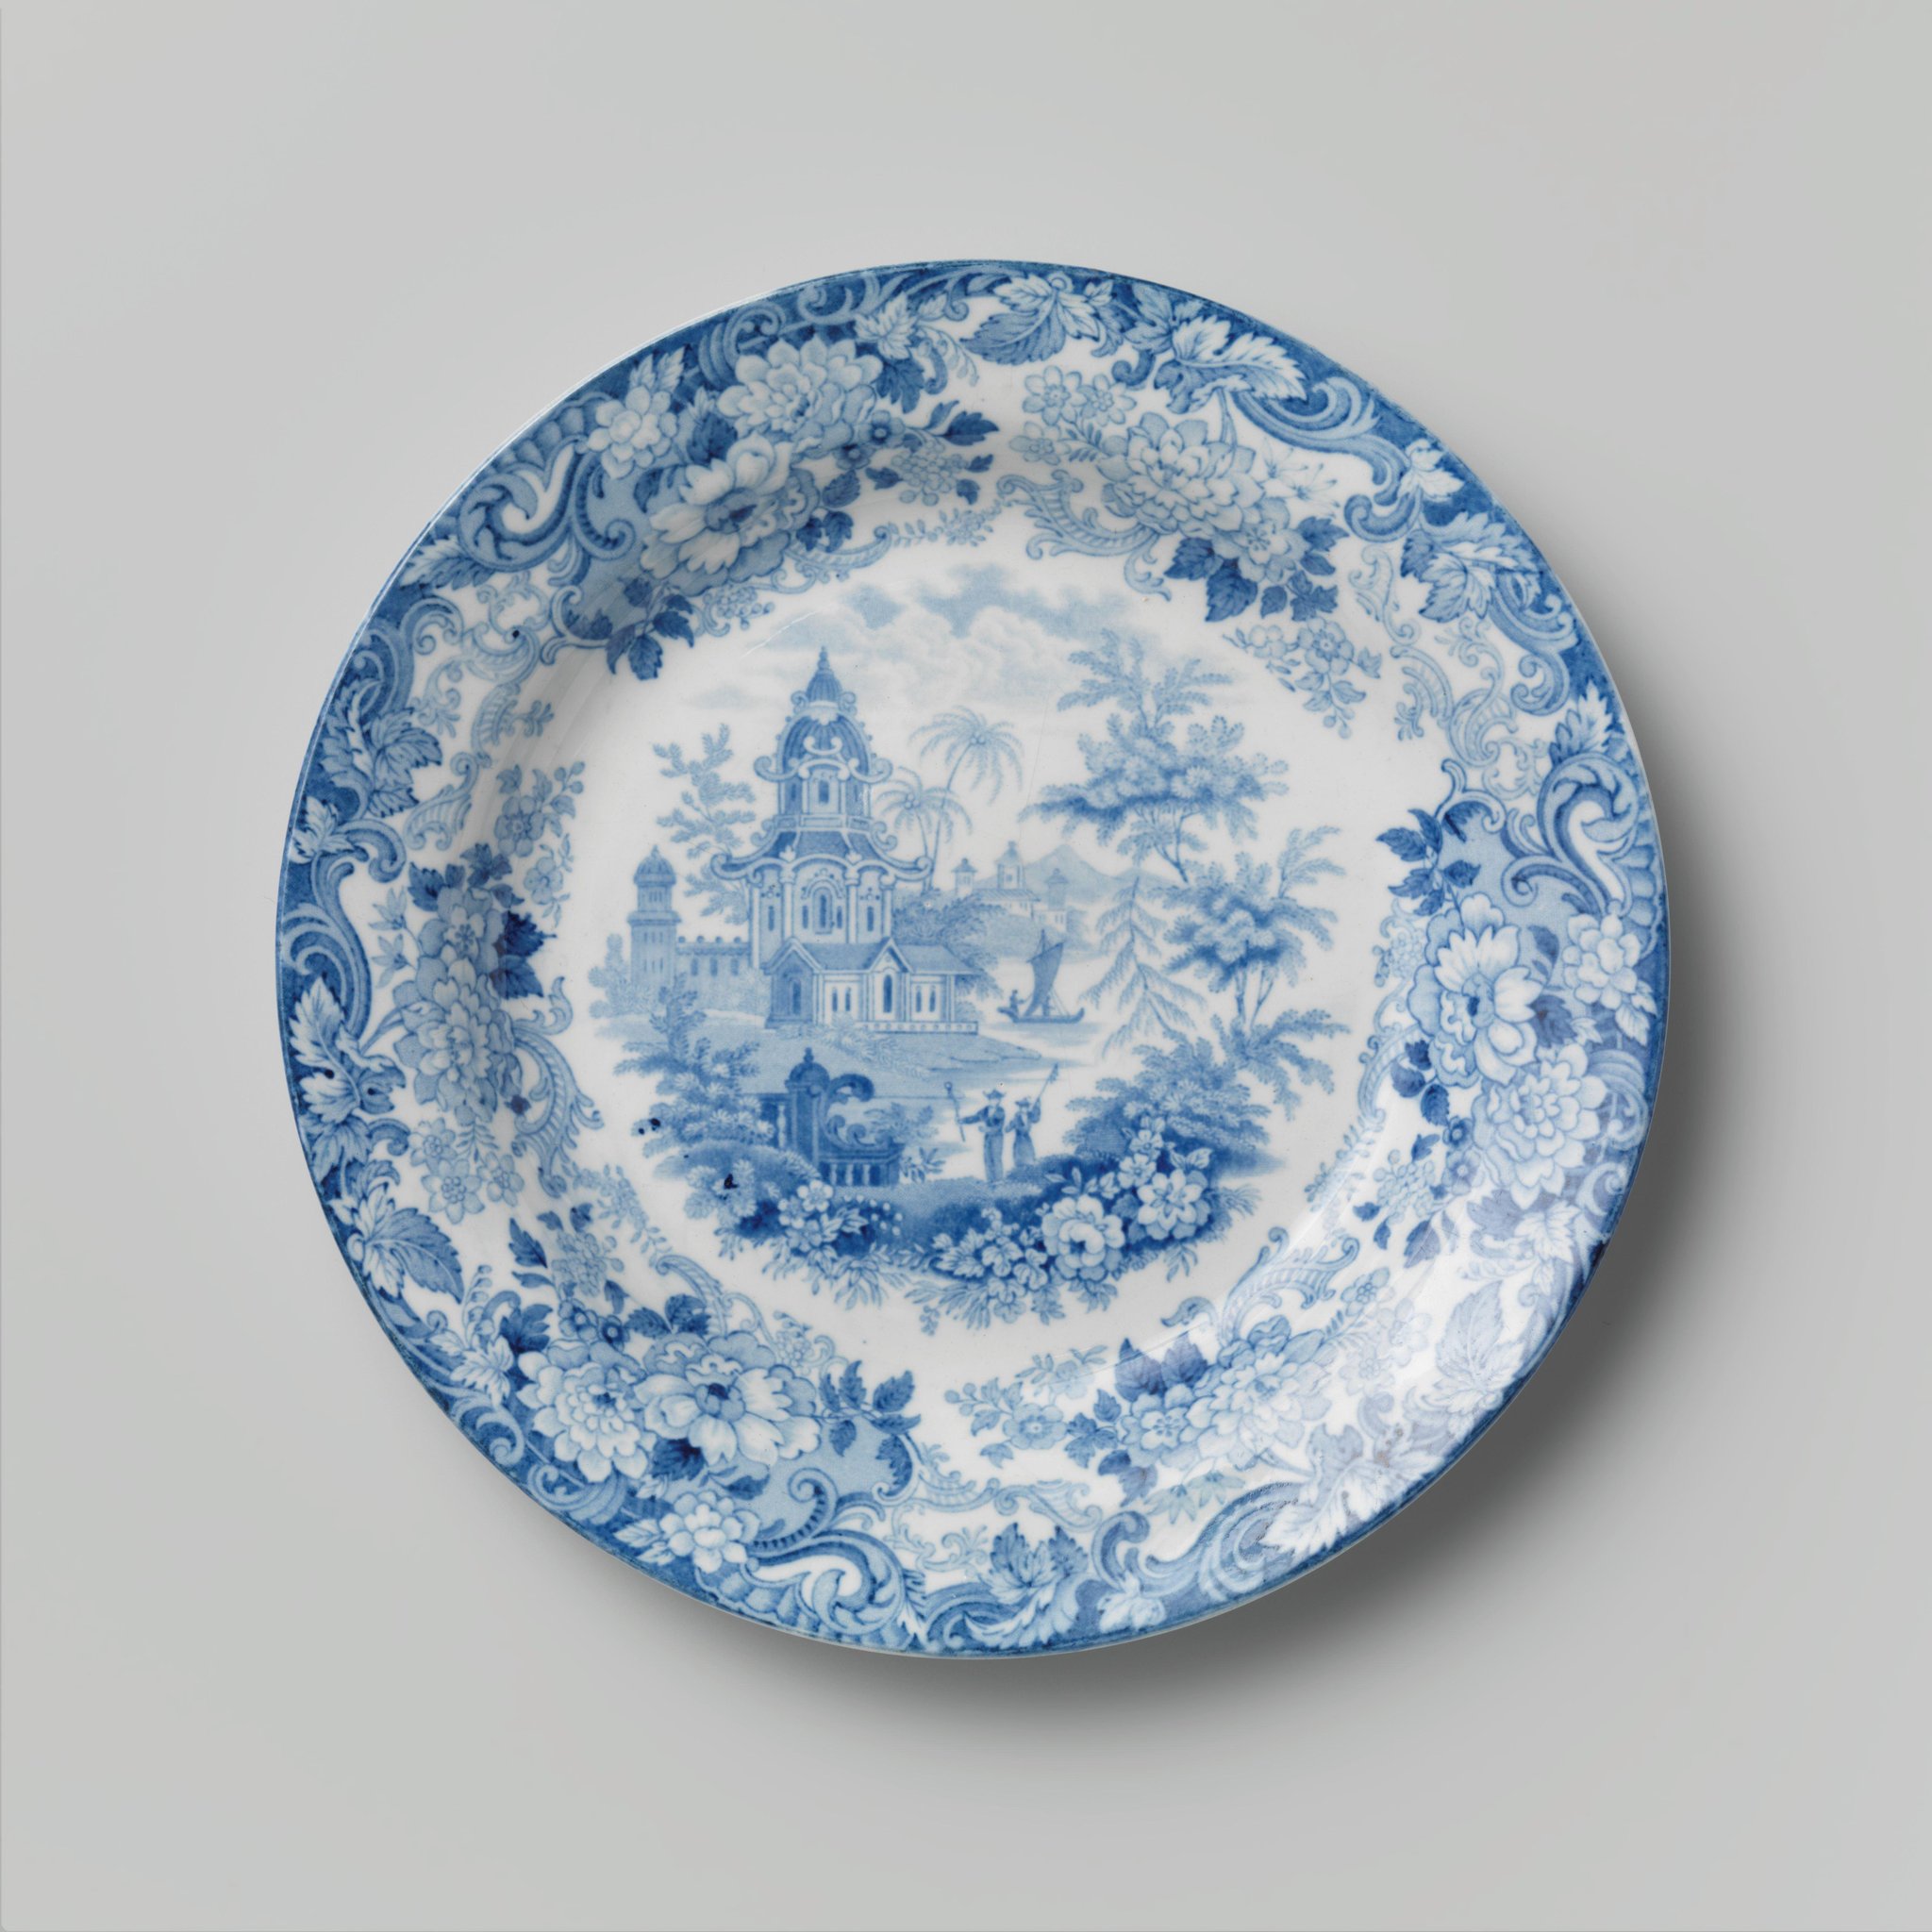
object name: plate dish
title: Rond bord van hardgebakken aardewerk met een blauwe decoratie; Wedgwood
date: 1840-1860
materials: earthenware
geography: england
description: Rond bord van hardgebakken aardewerk, met een decoratie onder de glazuur in transfertechniek. De decoratie is in blauw en heeft op het plat een voorstelling van een landschap waarin een gebouw (Chinese pagode ?), bomen en figuren. De rand heeft bloemen en acanthusbladeren. Het bord is gemerkt: Wedgwood AA.